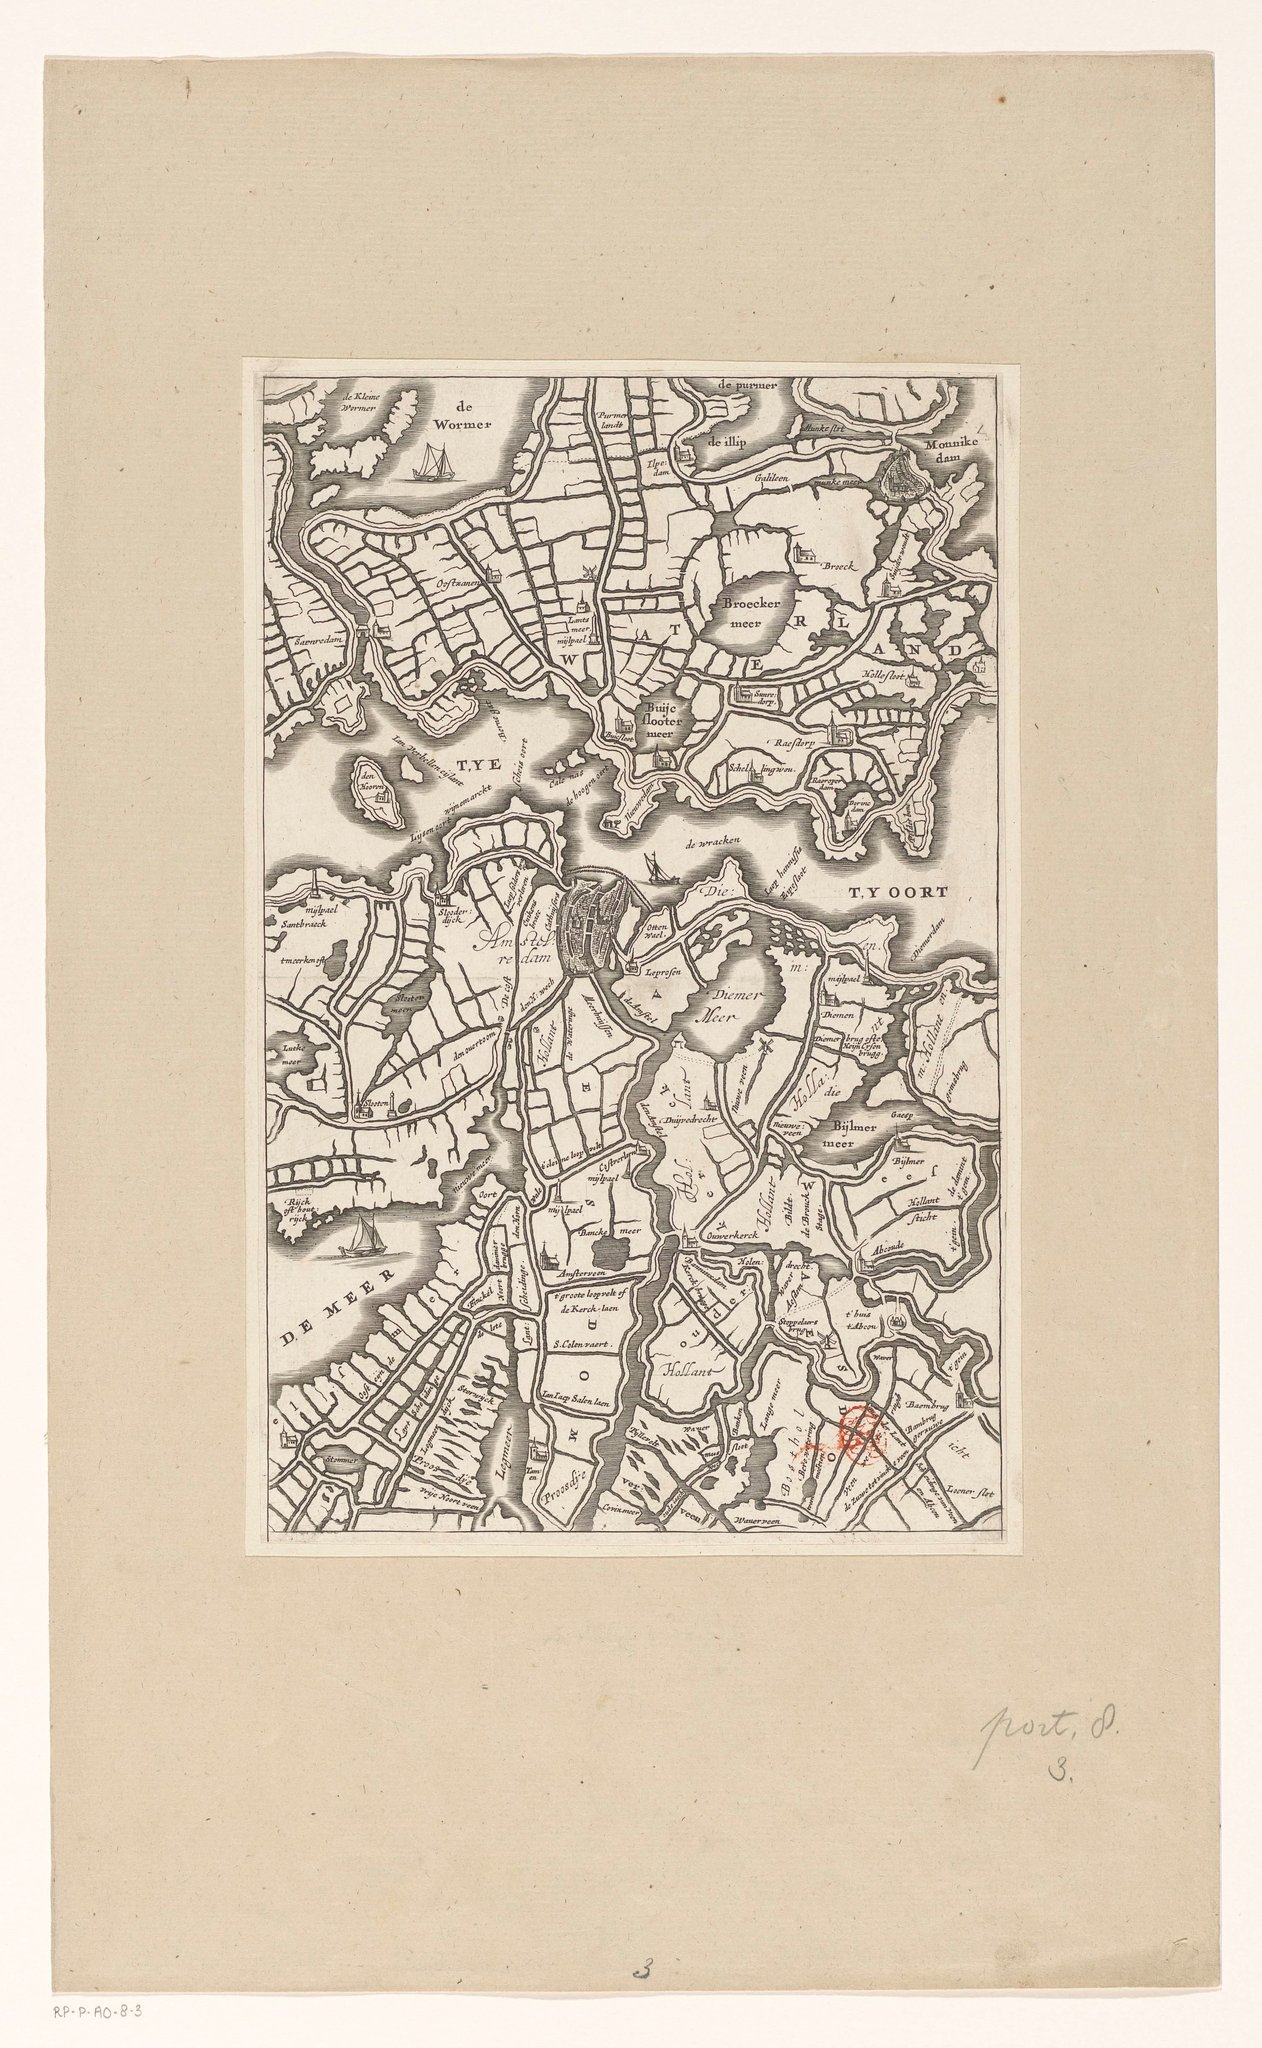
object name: map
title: Kaart van het gebied rond Amsterdam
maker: Anonymous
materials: paper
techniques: engraving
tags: maps of cities, amsterdam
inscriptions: collector's mark: Lugt 195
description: Kaart van het gebied rond Amsterdam. Weergeeft de situatie voor de drooglegging van de vele meren in het gebied (in ieder geval voor 1644: drooglegging van het Slotermeer). Deze kaart is echter later gemaakt, in de stijl van een grote kaart van Holland van Joost Jansz. Bilhamer (zie RP-P-AO-7-2 en RP-P-AO-7-65).